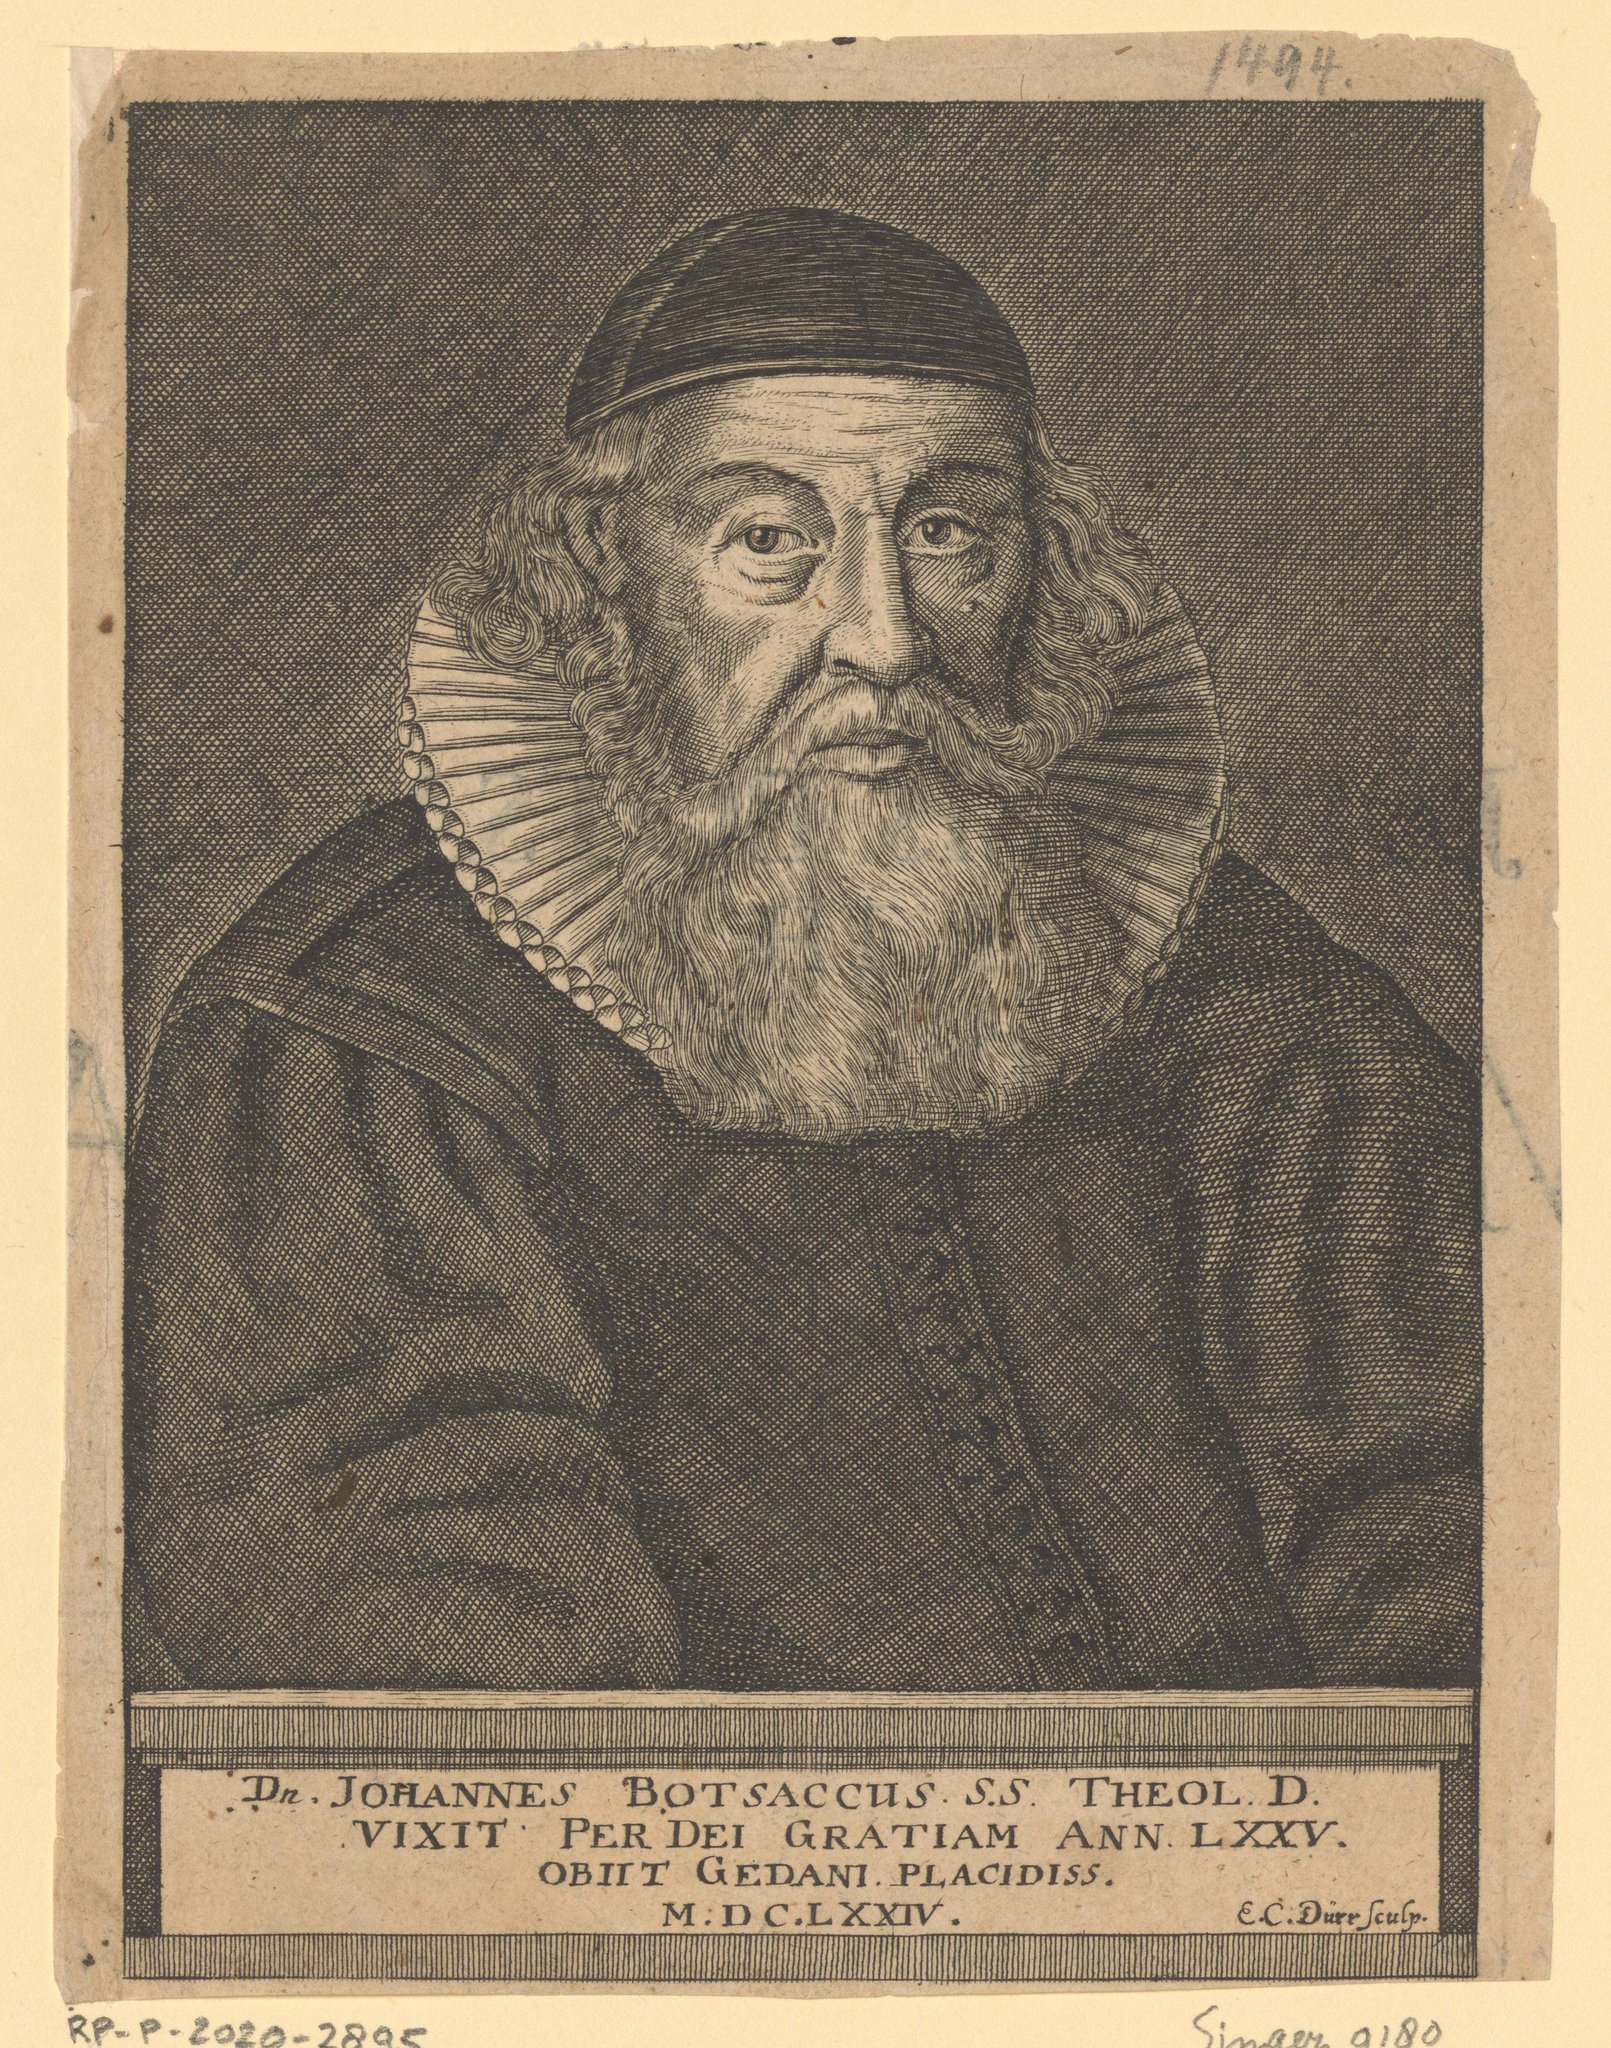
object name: print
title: Portret van Johann Botsack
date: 1712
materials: paper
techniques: engraving, letterpress printing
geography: leipzig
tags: theologian, historical persons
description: Prent uit: Botsack, Johann. Moralia gedanensia. Leipzig: Thomas Fritsch, 1712.